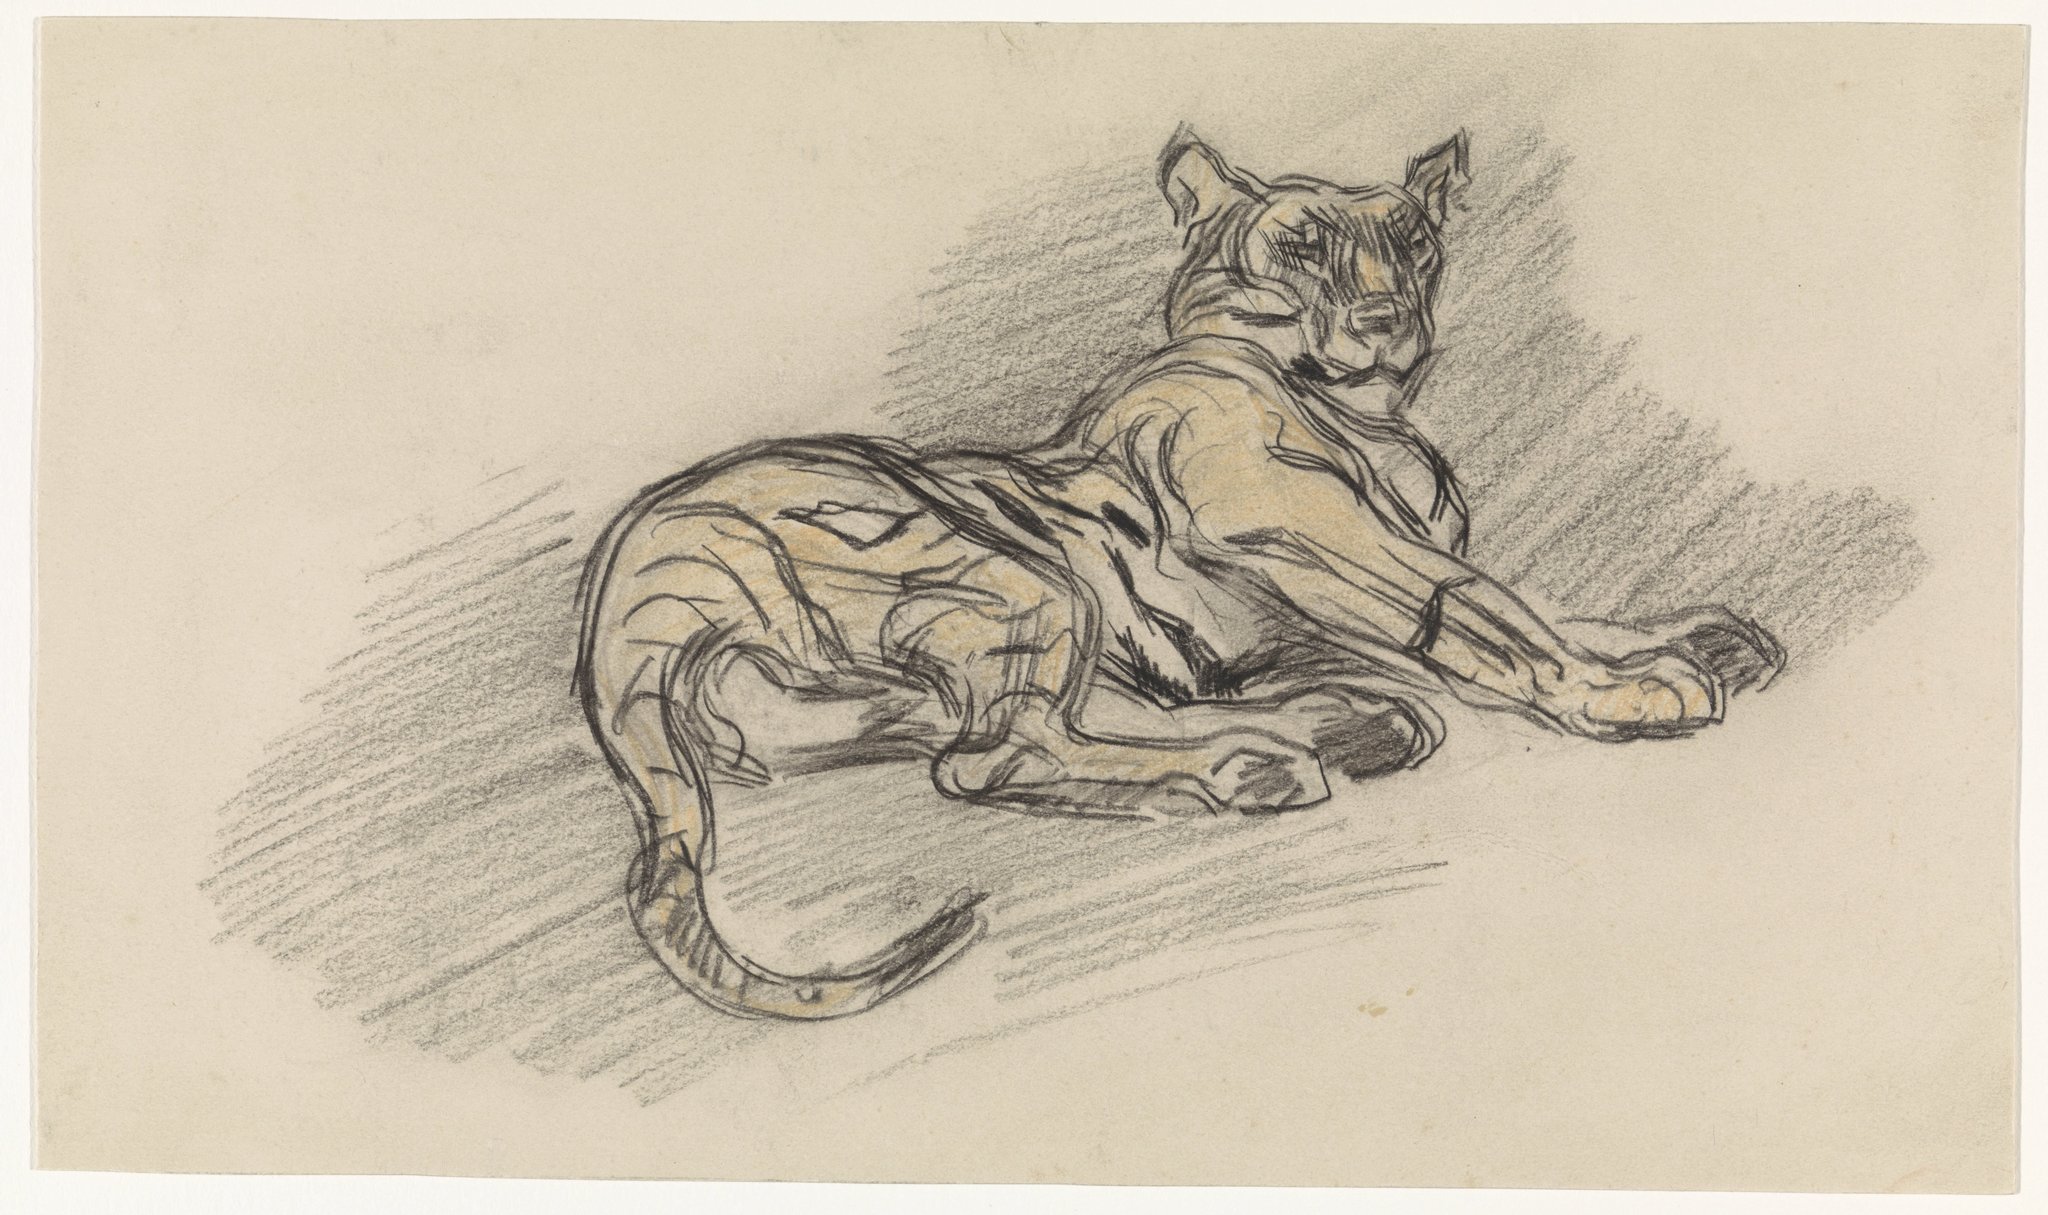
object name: drawing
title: Liggende tijger, naar rechts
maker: jan van essen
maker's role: draughtsman, print maker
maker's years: 1854-1936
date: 1864-1936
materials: chalk, paper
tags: beasts of prey, predatory animals: tiger